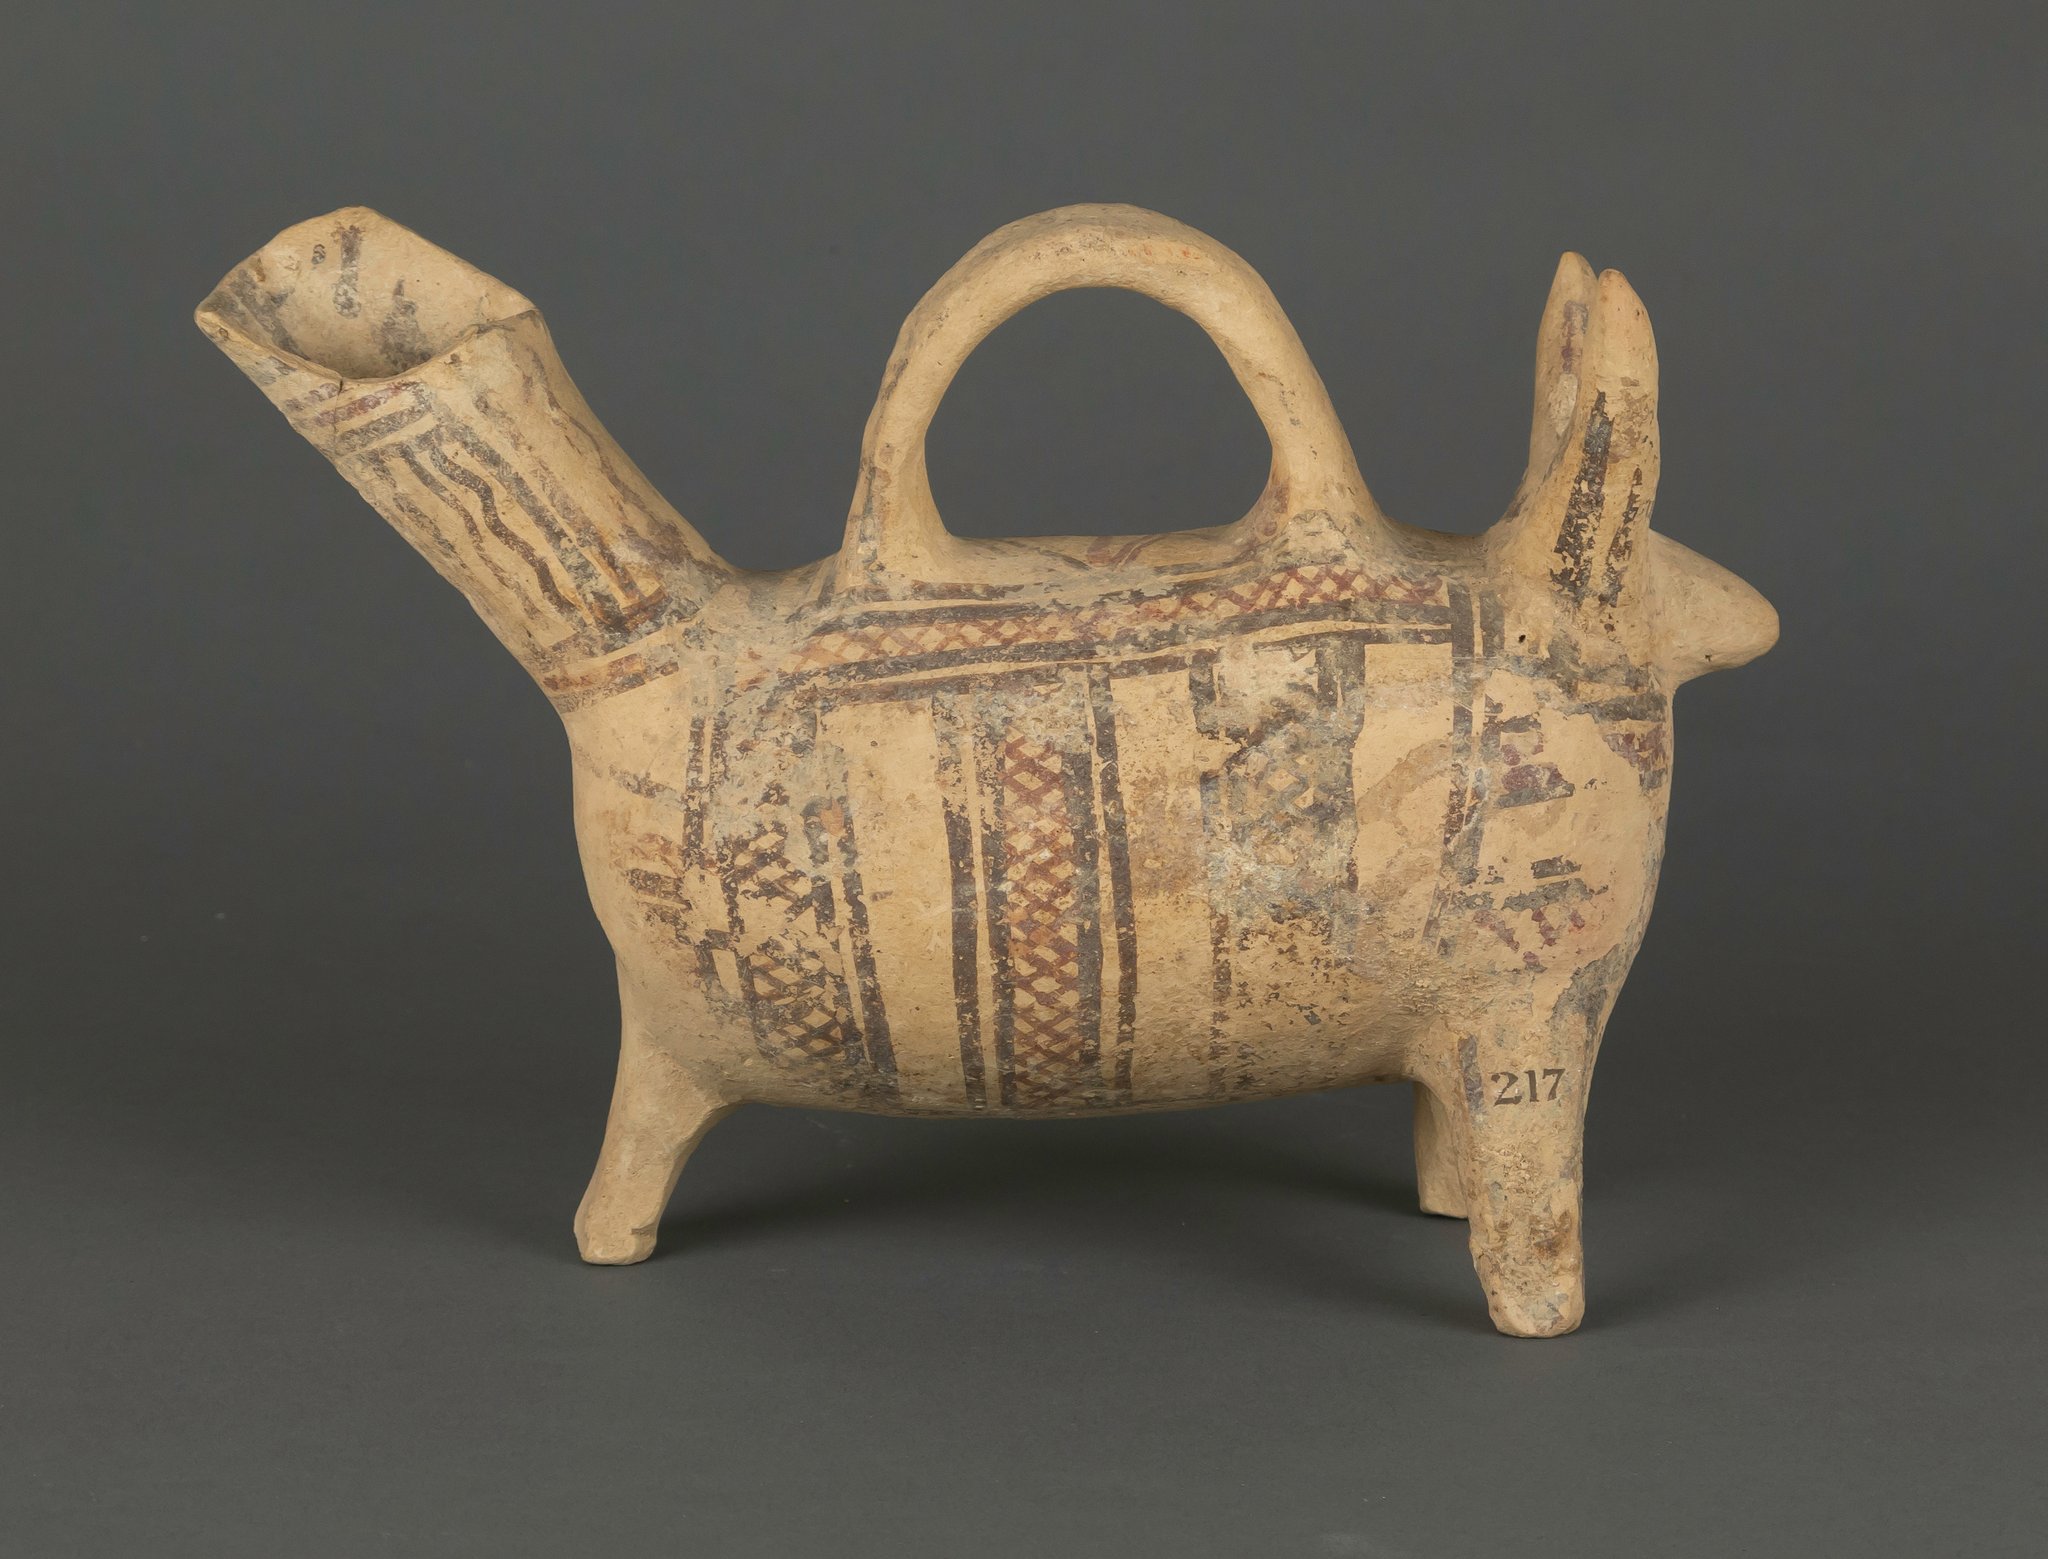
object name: askos in the form of an animal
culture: cypriot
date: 1900-1600 BCE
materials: terracotta